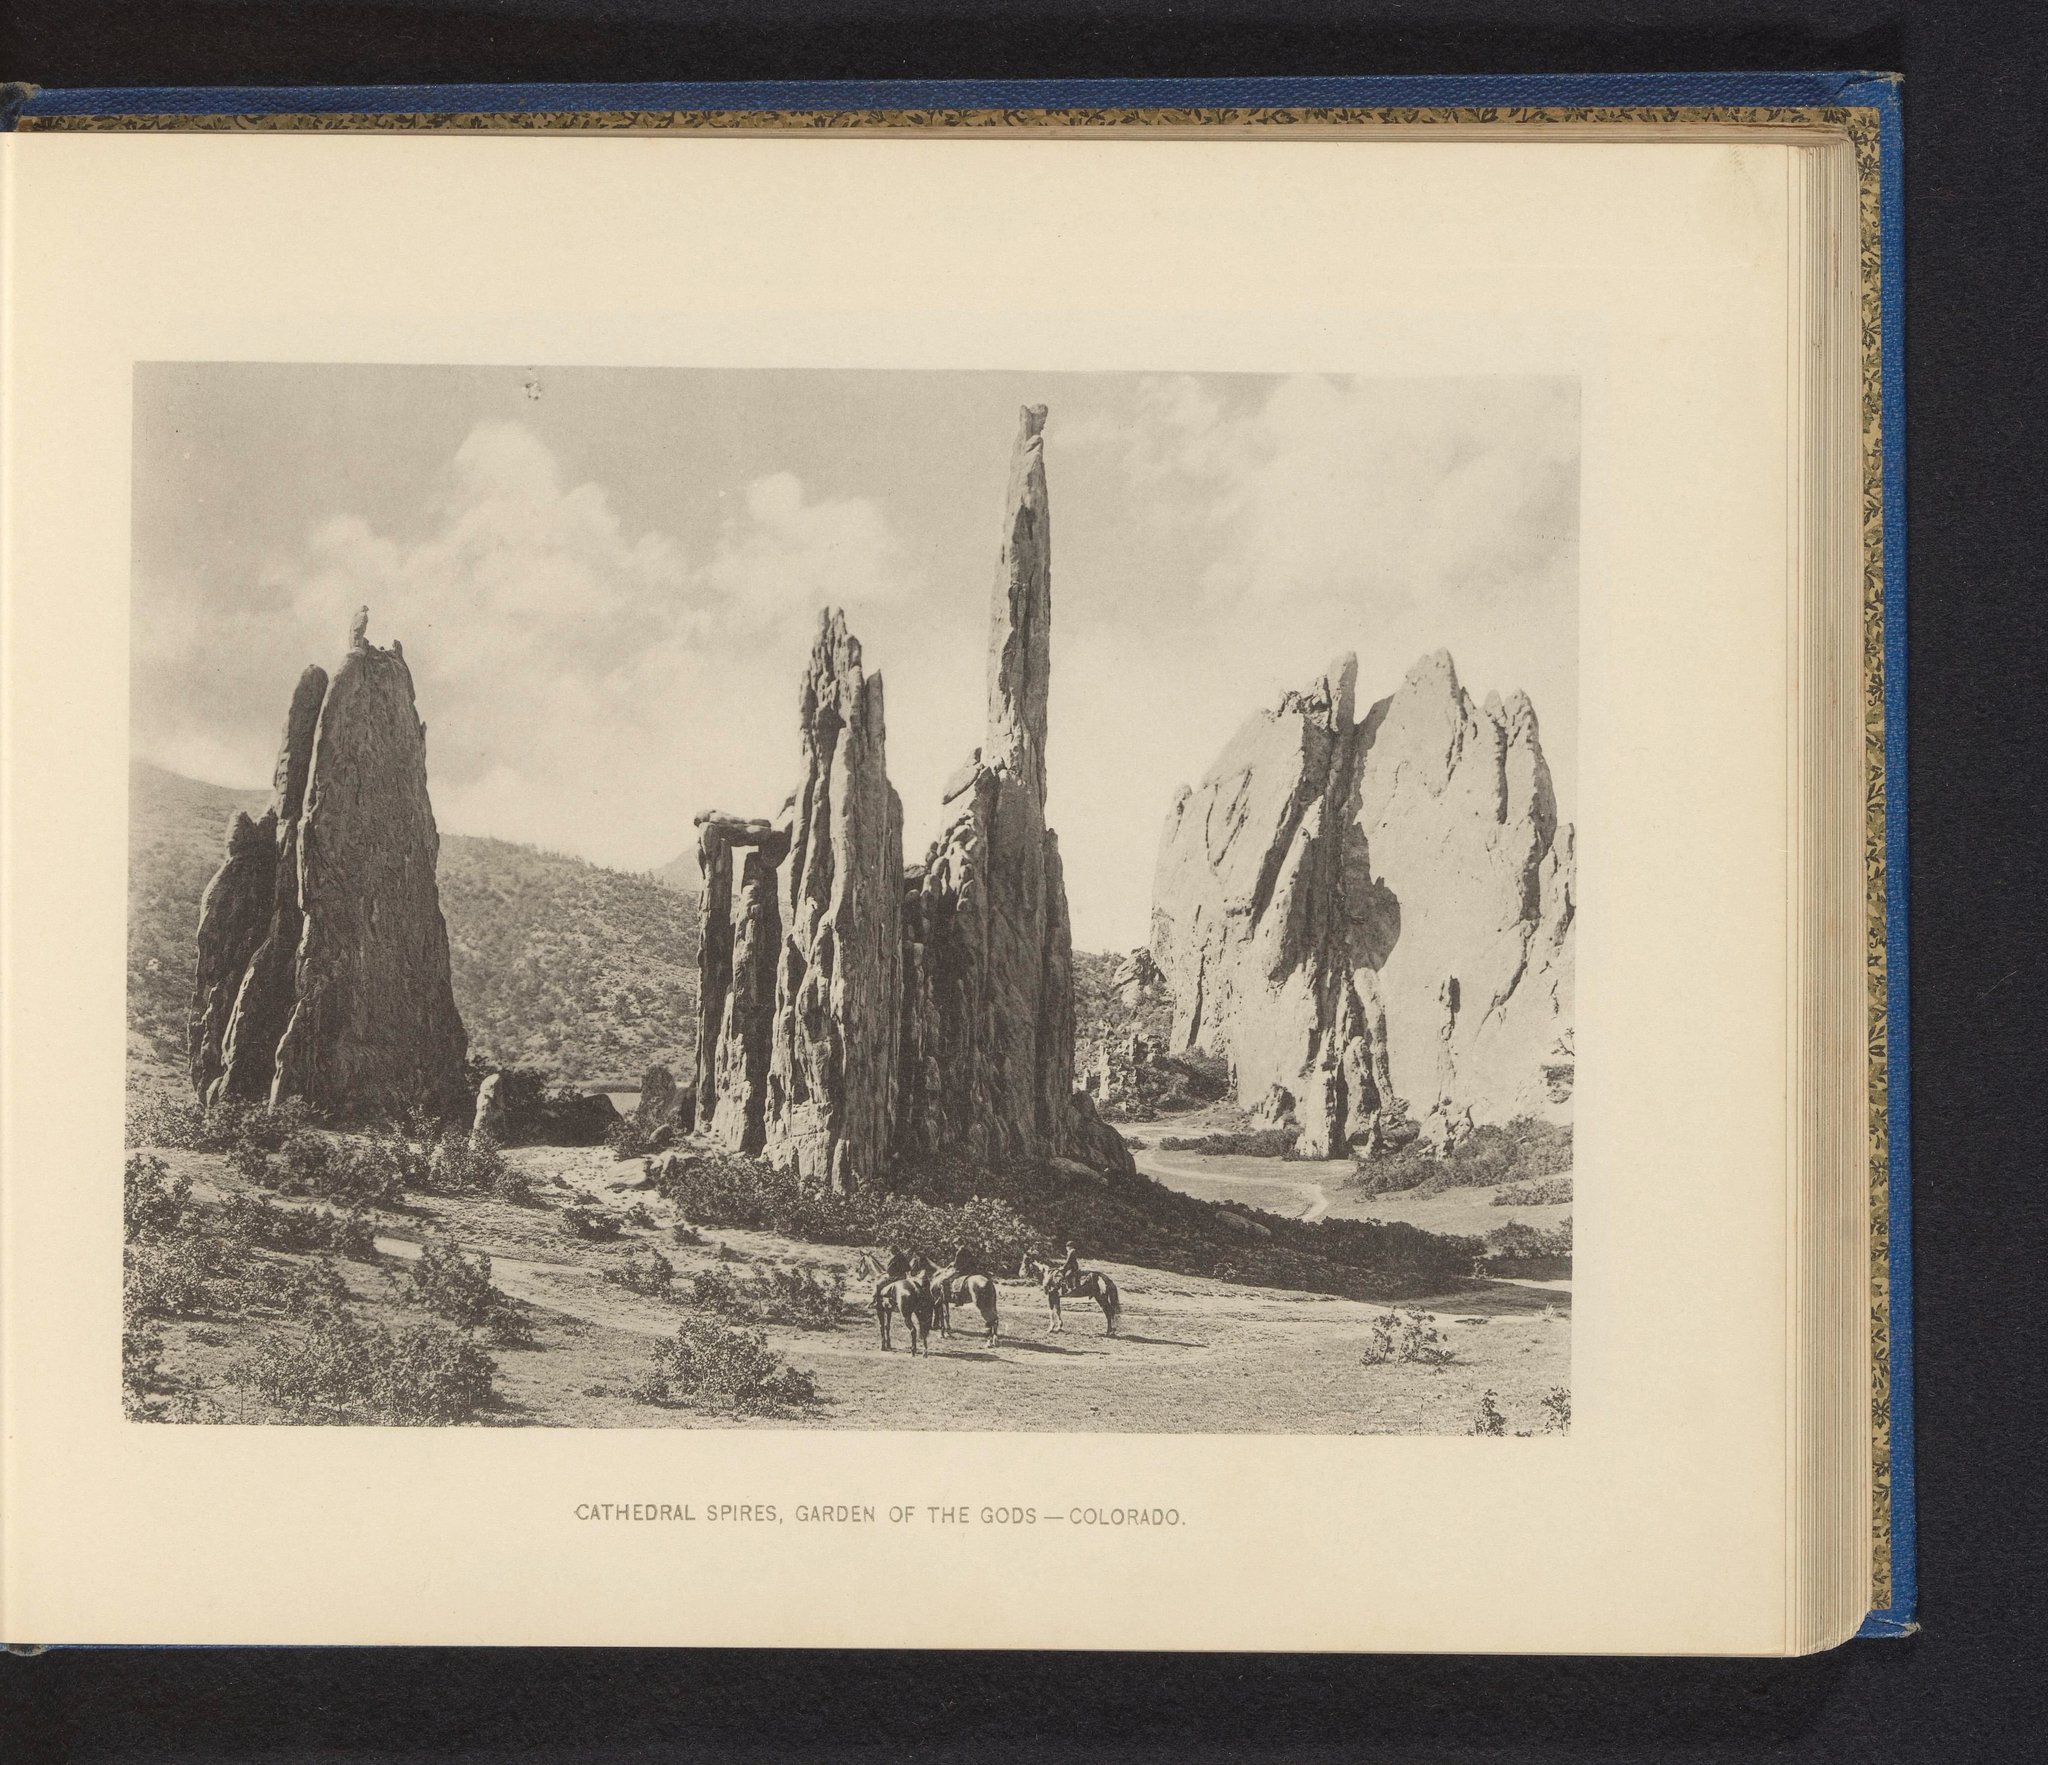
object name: page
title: Gezicht op de rotsformatie Cathedral Spires in de Tuin der goden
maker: Anonymous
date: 1883-1893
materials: paper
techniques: photograph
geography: tuin der goden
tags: rock-formations